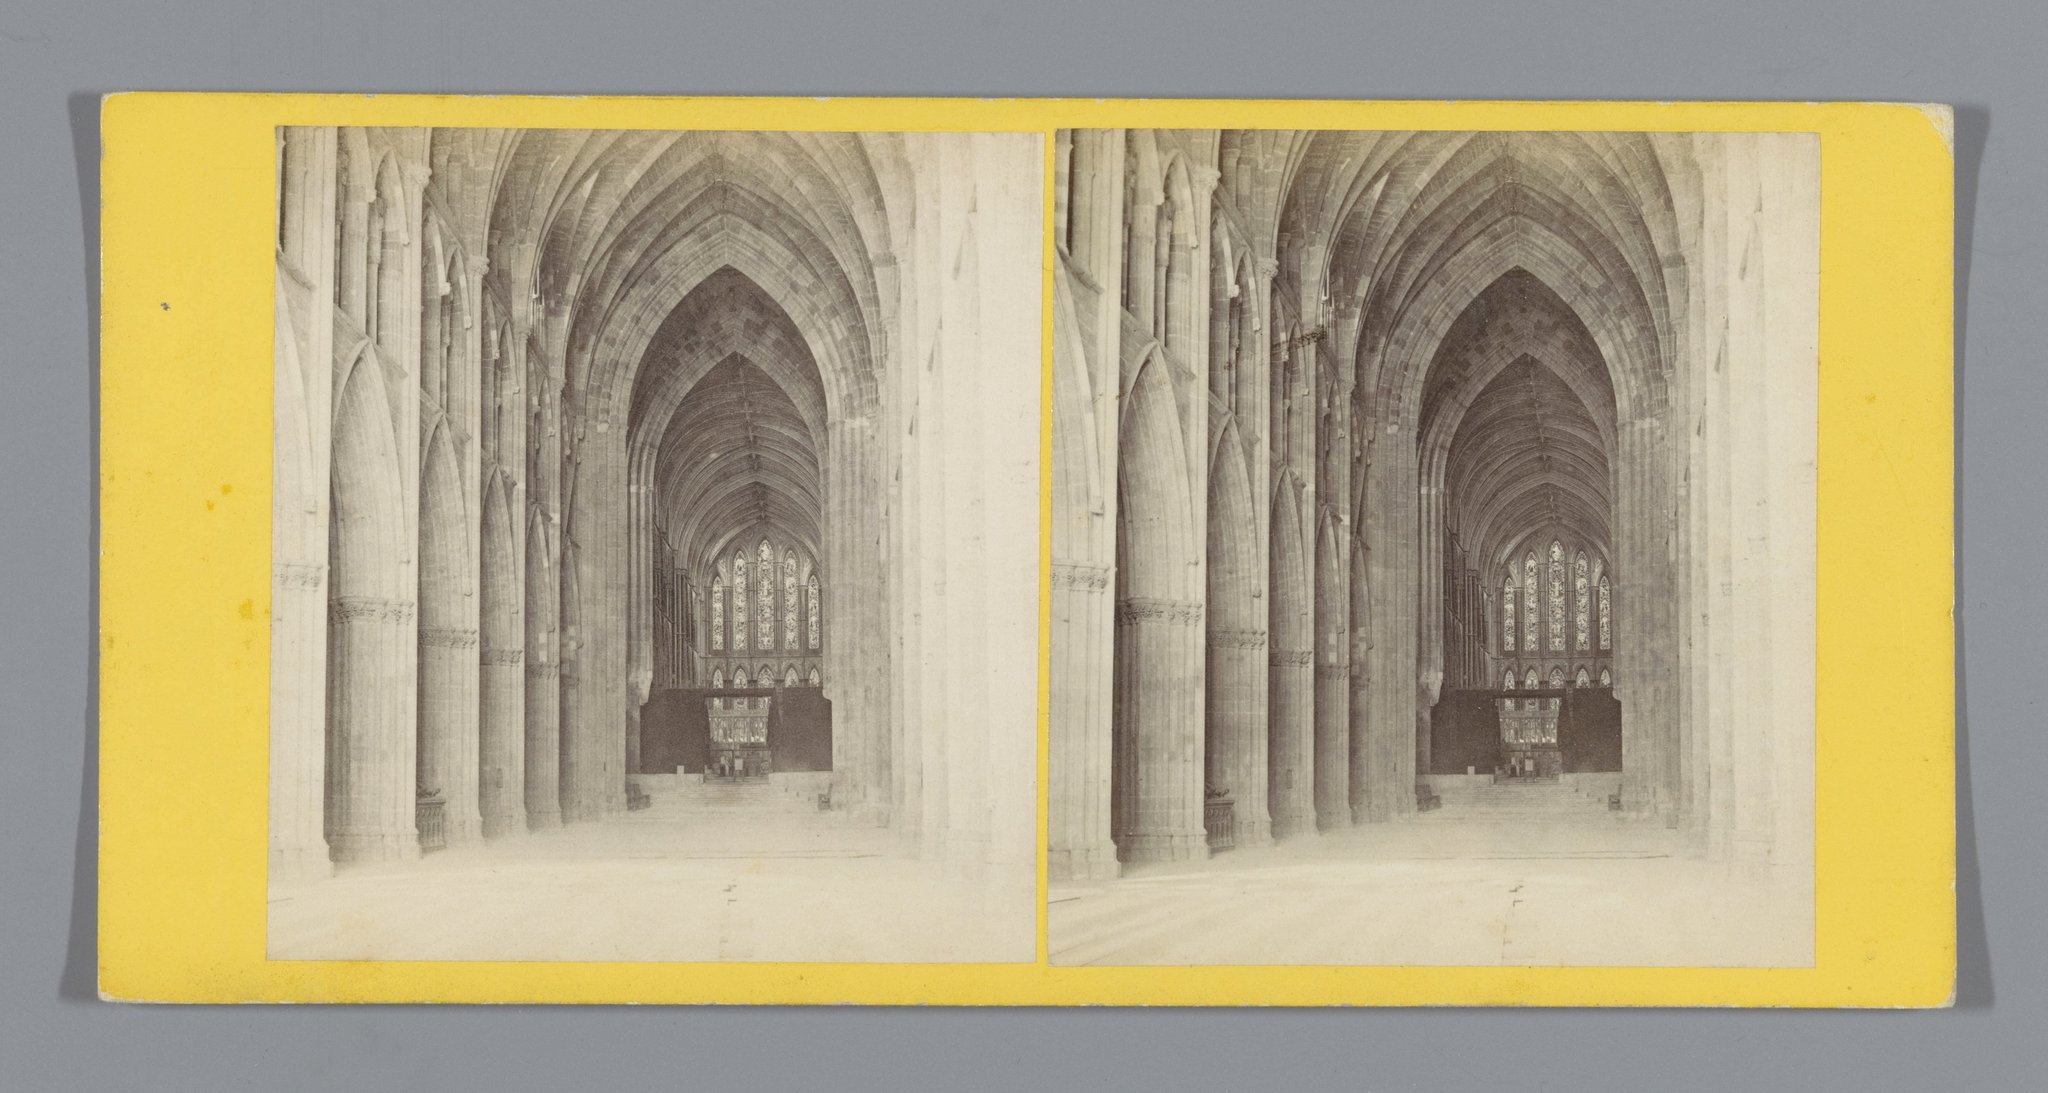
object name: stereograph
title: Interieur van het schip van de kathedraal van Worcester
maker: george washington wilson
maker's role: publisher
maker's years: 1823-1893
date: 1858-1872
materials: cardboard, photographic support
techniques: albumen print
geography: worcester cathedral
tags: parts of church interior: nave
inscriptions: number: ‘No. 618.’